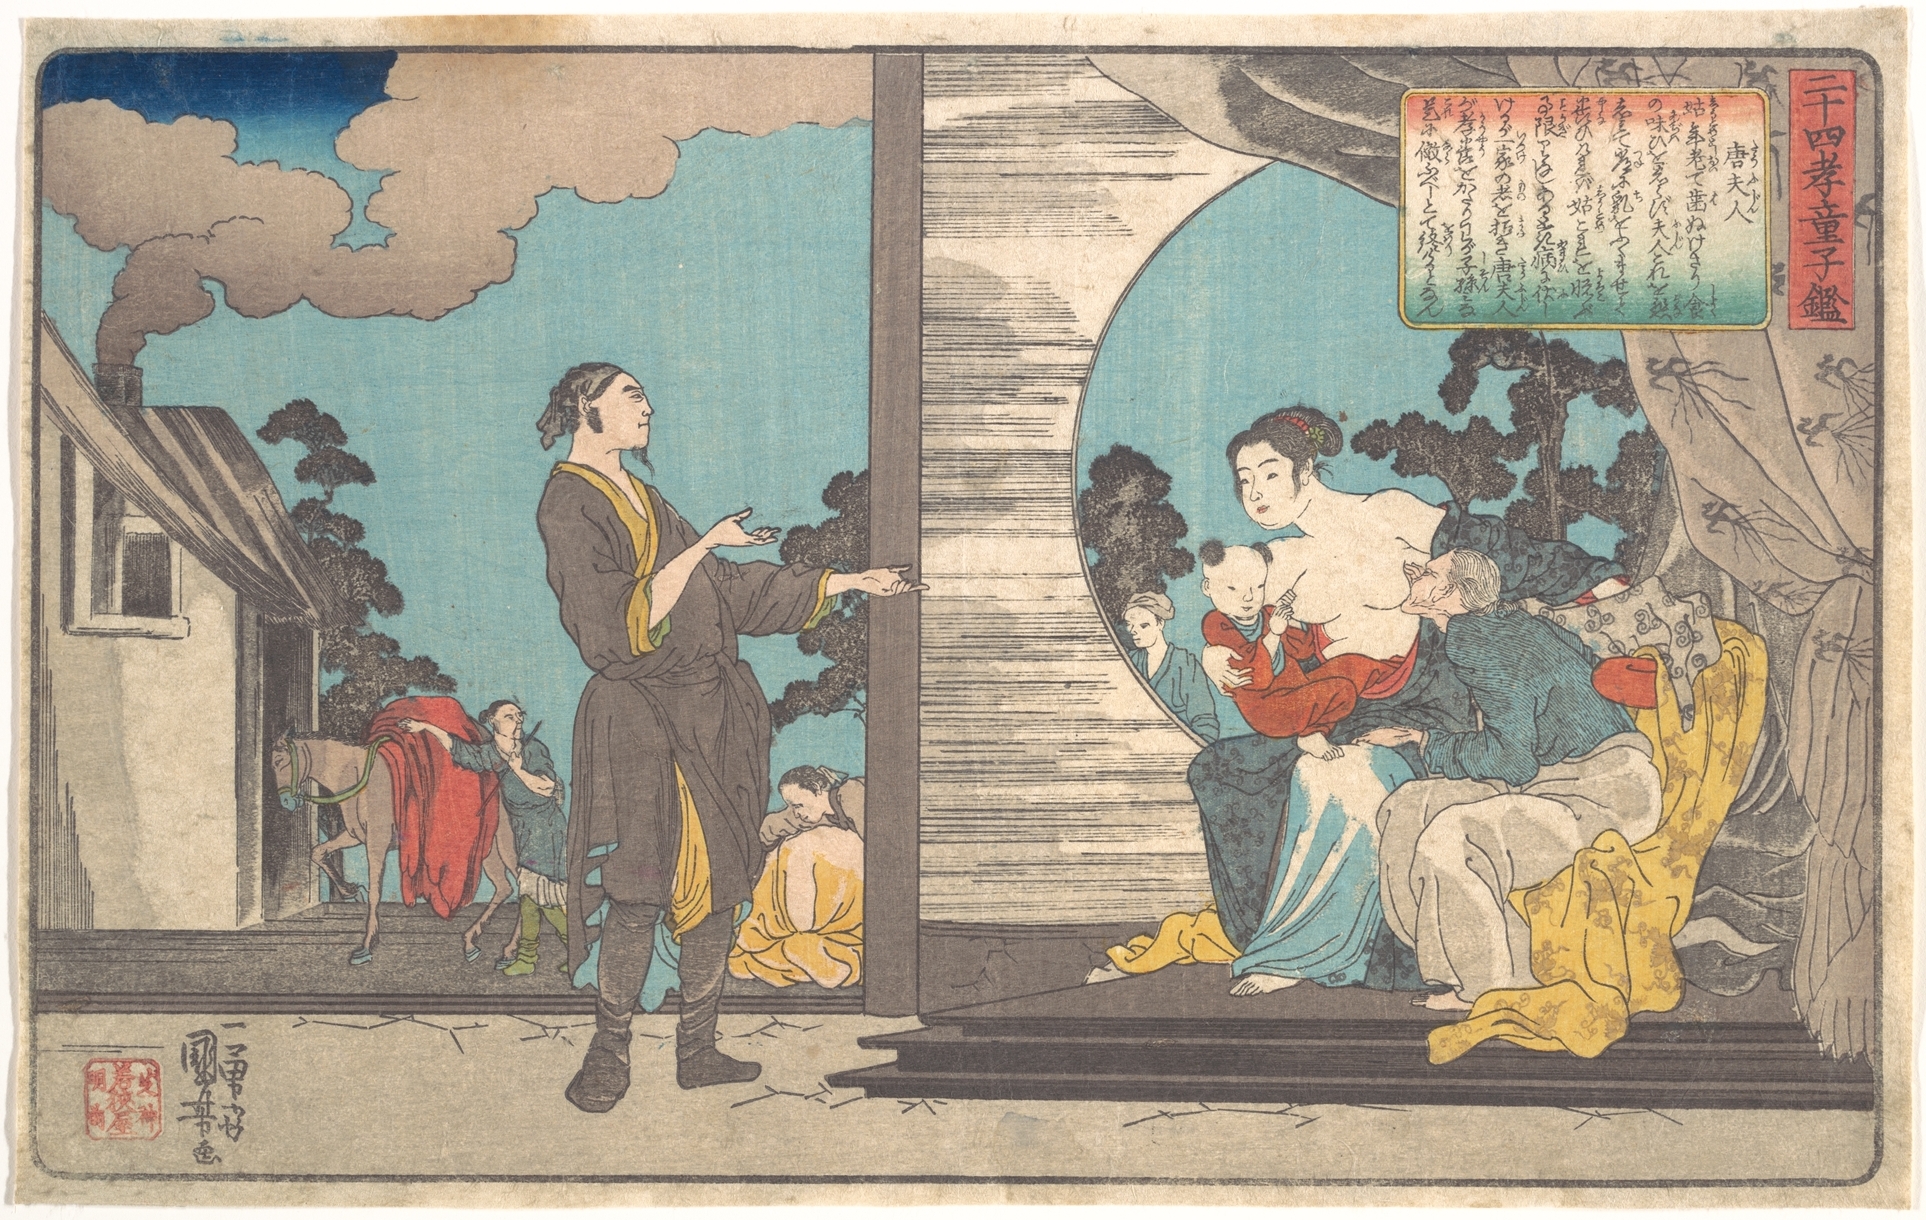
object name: print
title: Tang Furen, from the series Twenty-four Paragons of Filial Piety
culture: japanese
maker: utagawa kuniyoshi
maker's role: artist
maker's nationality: japanese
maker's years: 1797-1861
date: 1840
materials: ink, paper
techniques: woodblock print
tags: infants,men,women